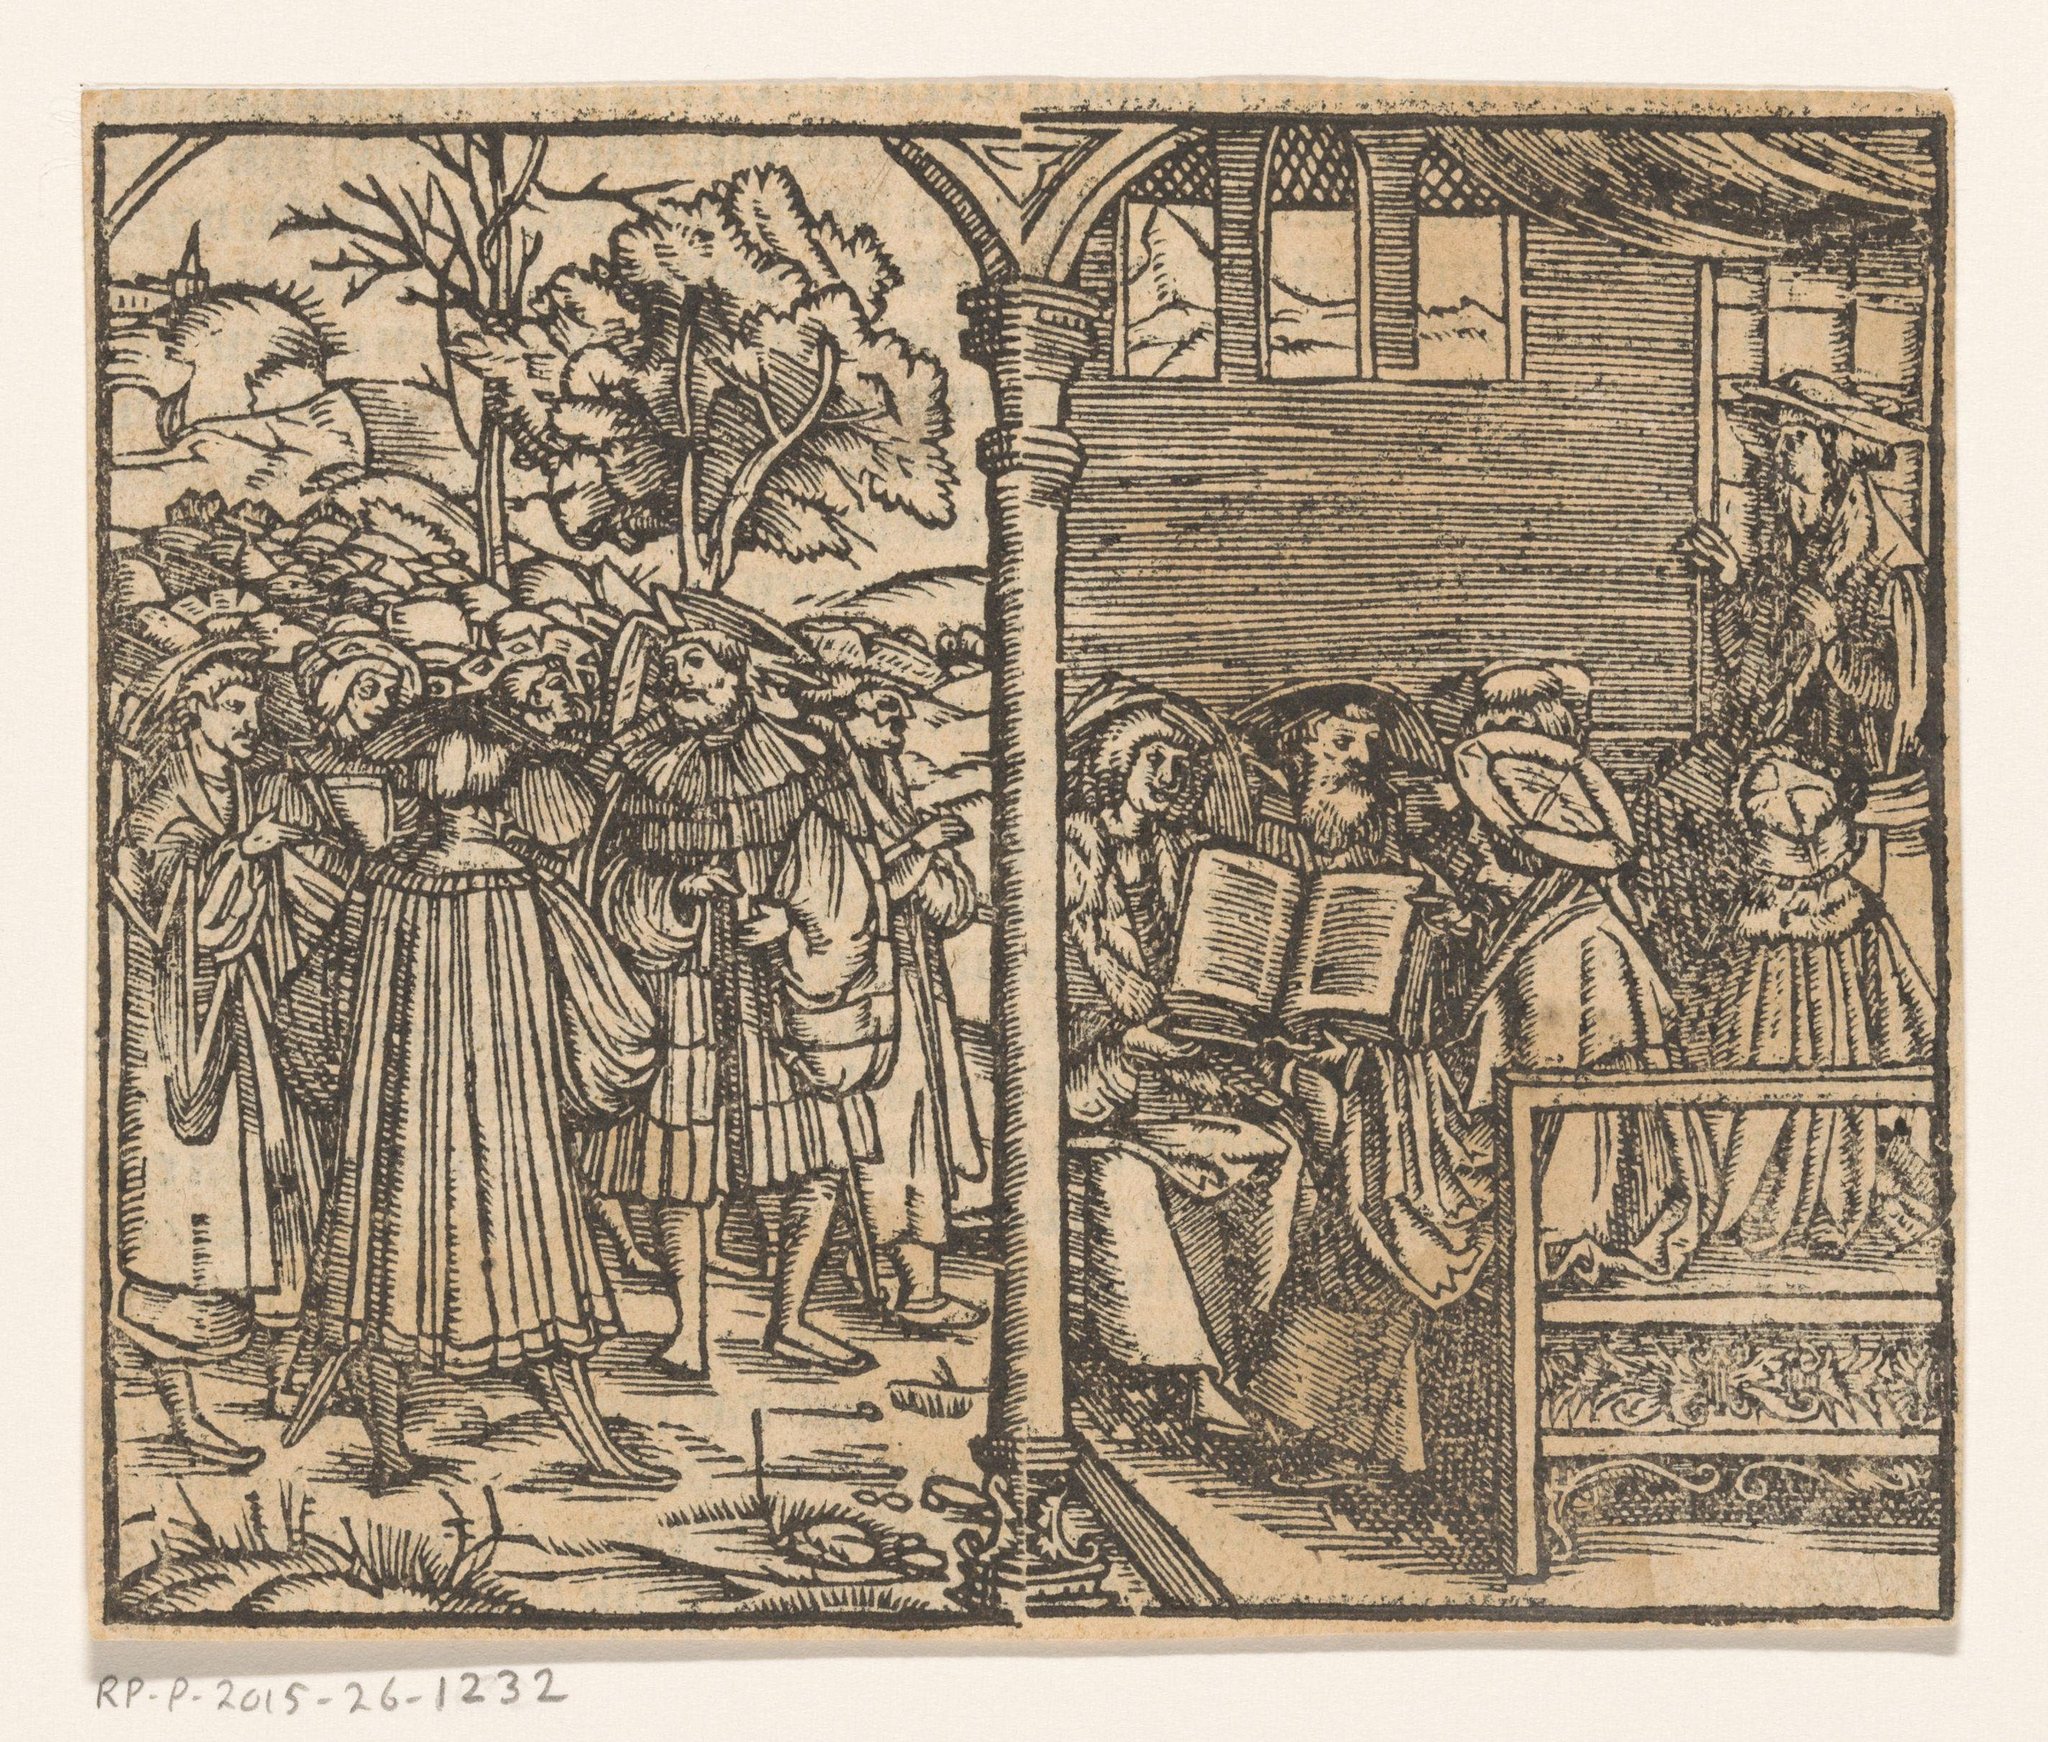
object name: print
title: Menigte in de buitenlucht en een interieur met een heerser op zijn troon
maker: Anonymous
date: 1475-1600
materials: paper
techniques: woodcut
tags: ruler, sovereign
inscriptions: collector's mark: Lugt 2228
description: Illustratie bestaande uit twee houtblokken, tegen elkaar gedrukt om een voorstelling te vormen.